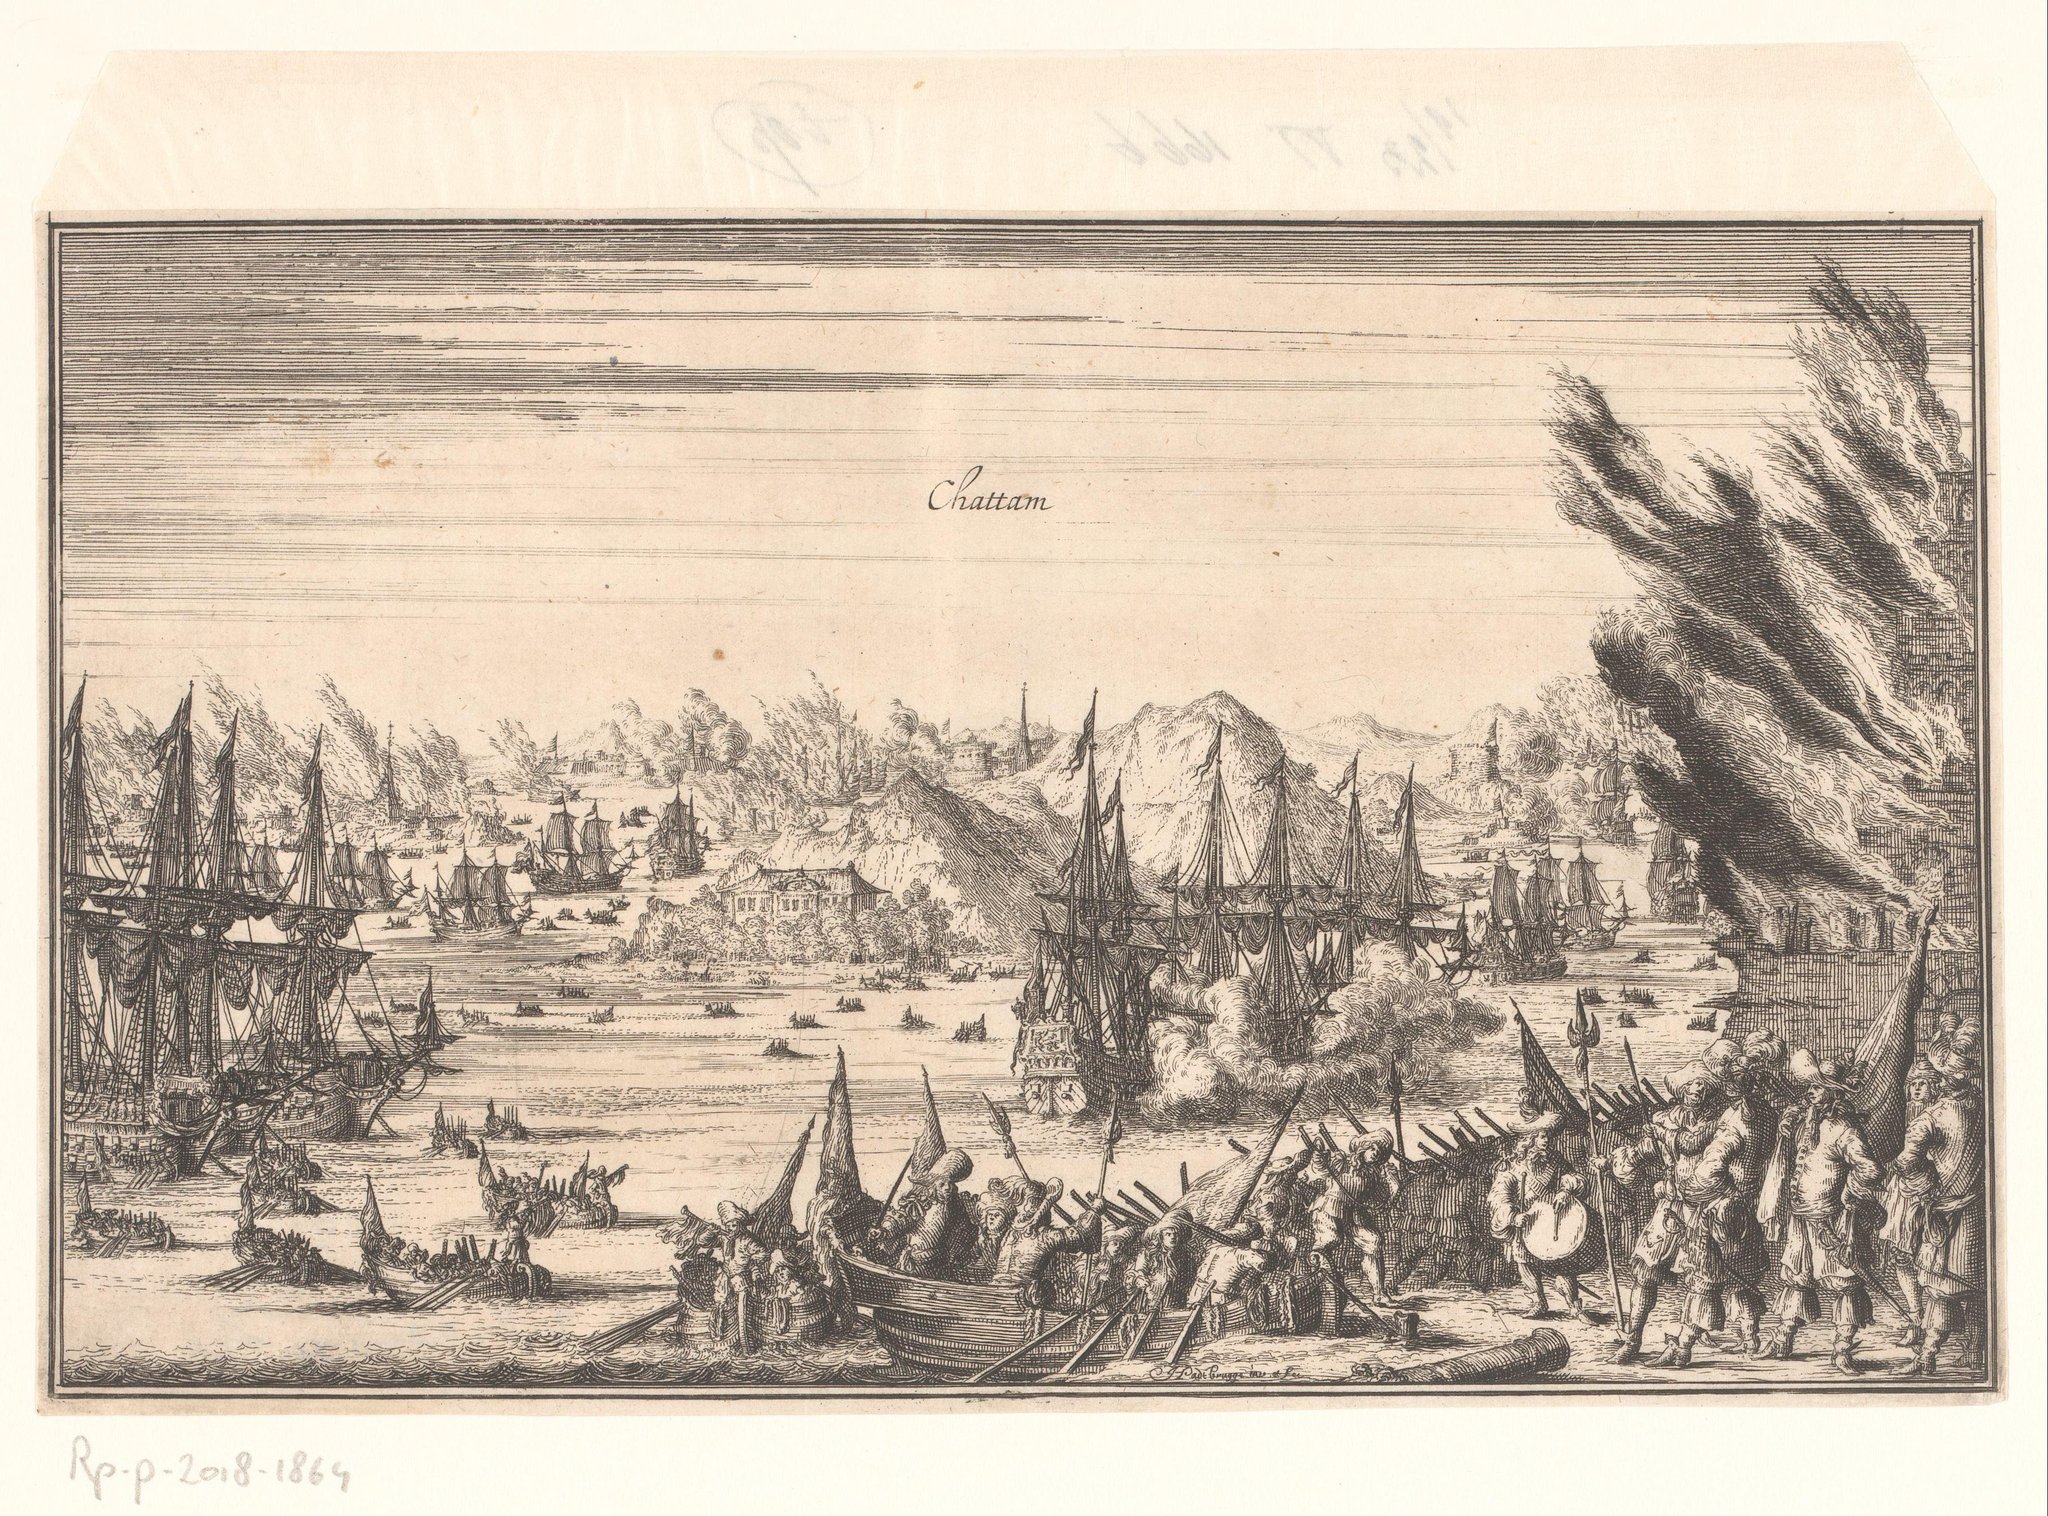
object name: history print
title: Tocht naar Chatham, 1667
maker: herman padtbrugge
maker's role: print maker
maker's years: 1656-1687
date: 1674-1676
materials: paper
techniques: etching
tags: flushing, michiel adriaenszoon de ruyter, battle (+ naval force), raid on the medway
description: De Tocht naar Chatham en de vernietiging van de Engelse vloot op 20 juni 1667 door de Staatse vloot onder Michiel Adriaenszoon de Ruyter. Rechts een groepje officieren bij een brandend gebouw.